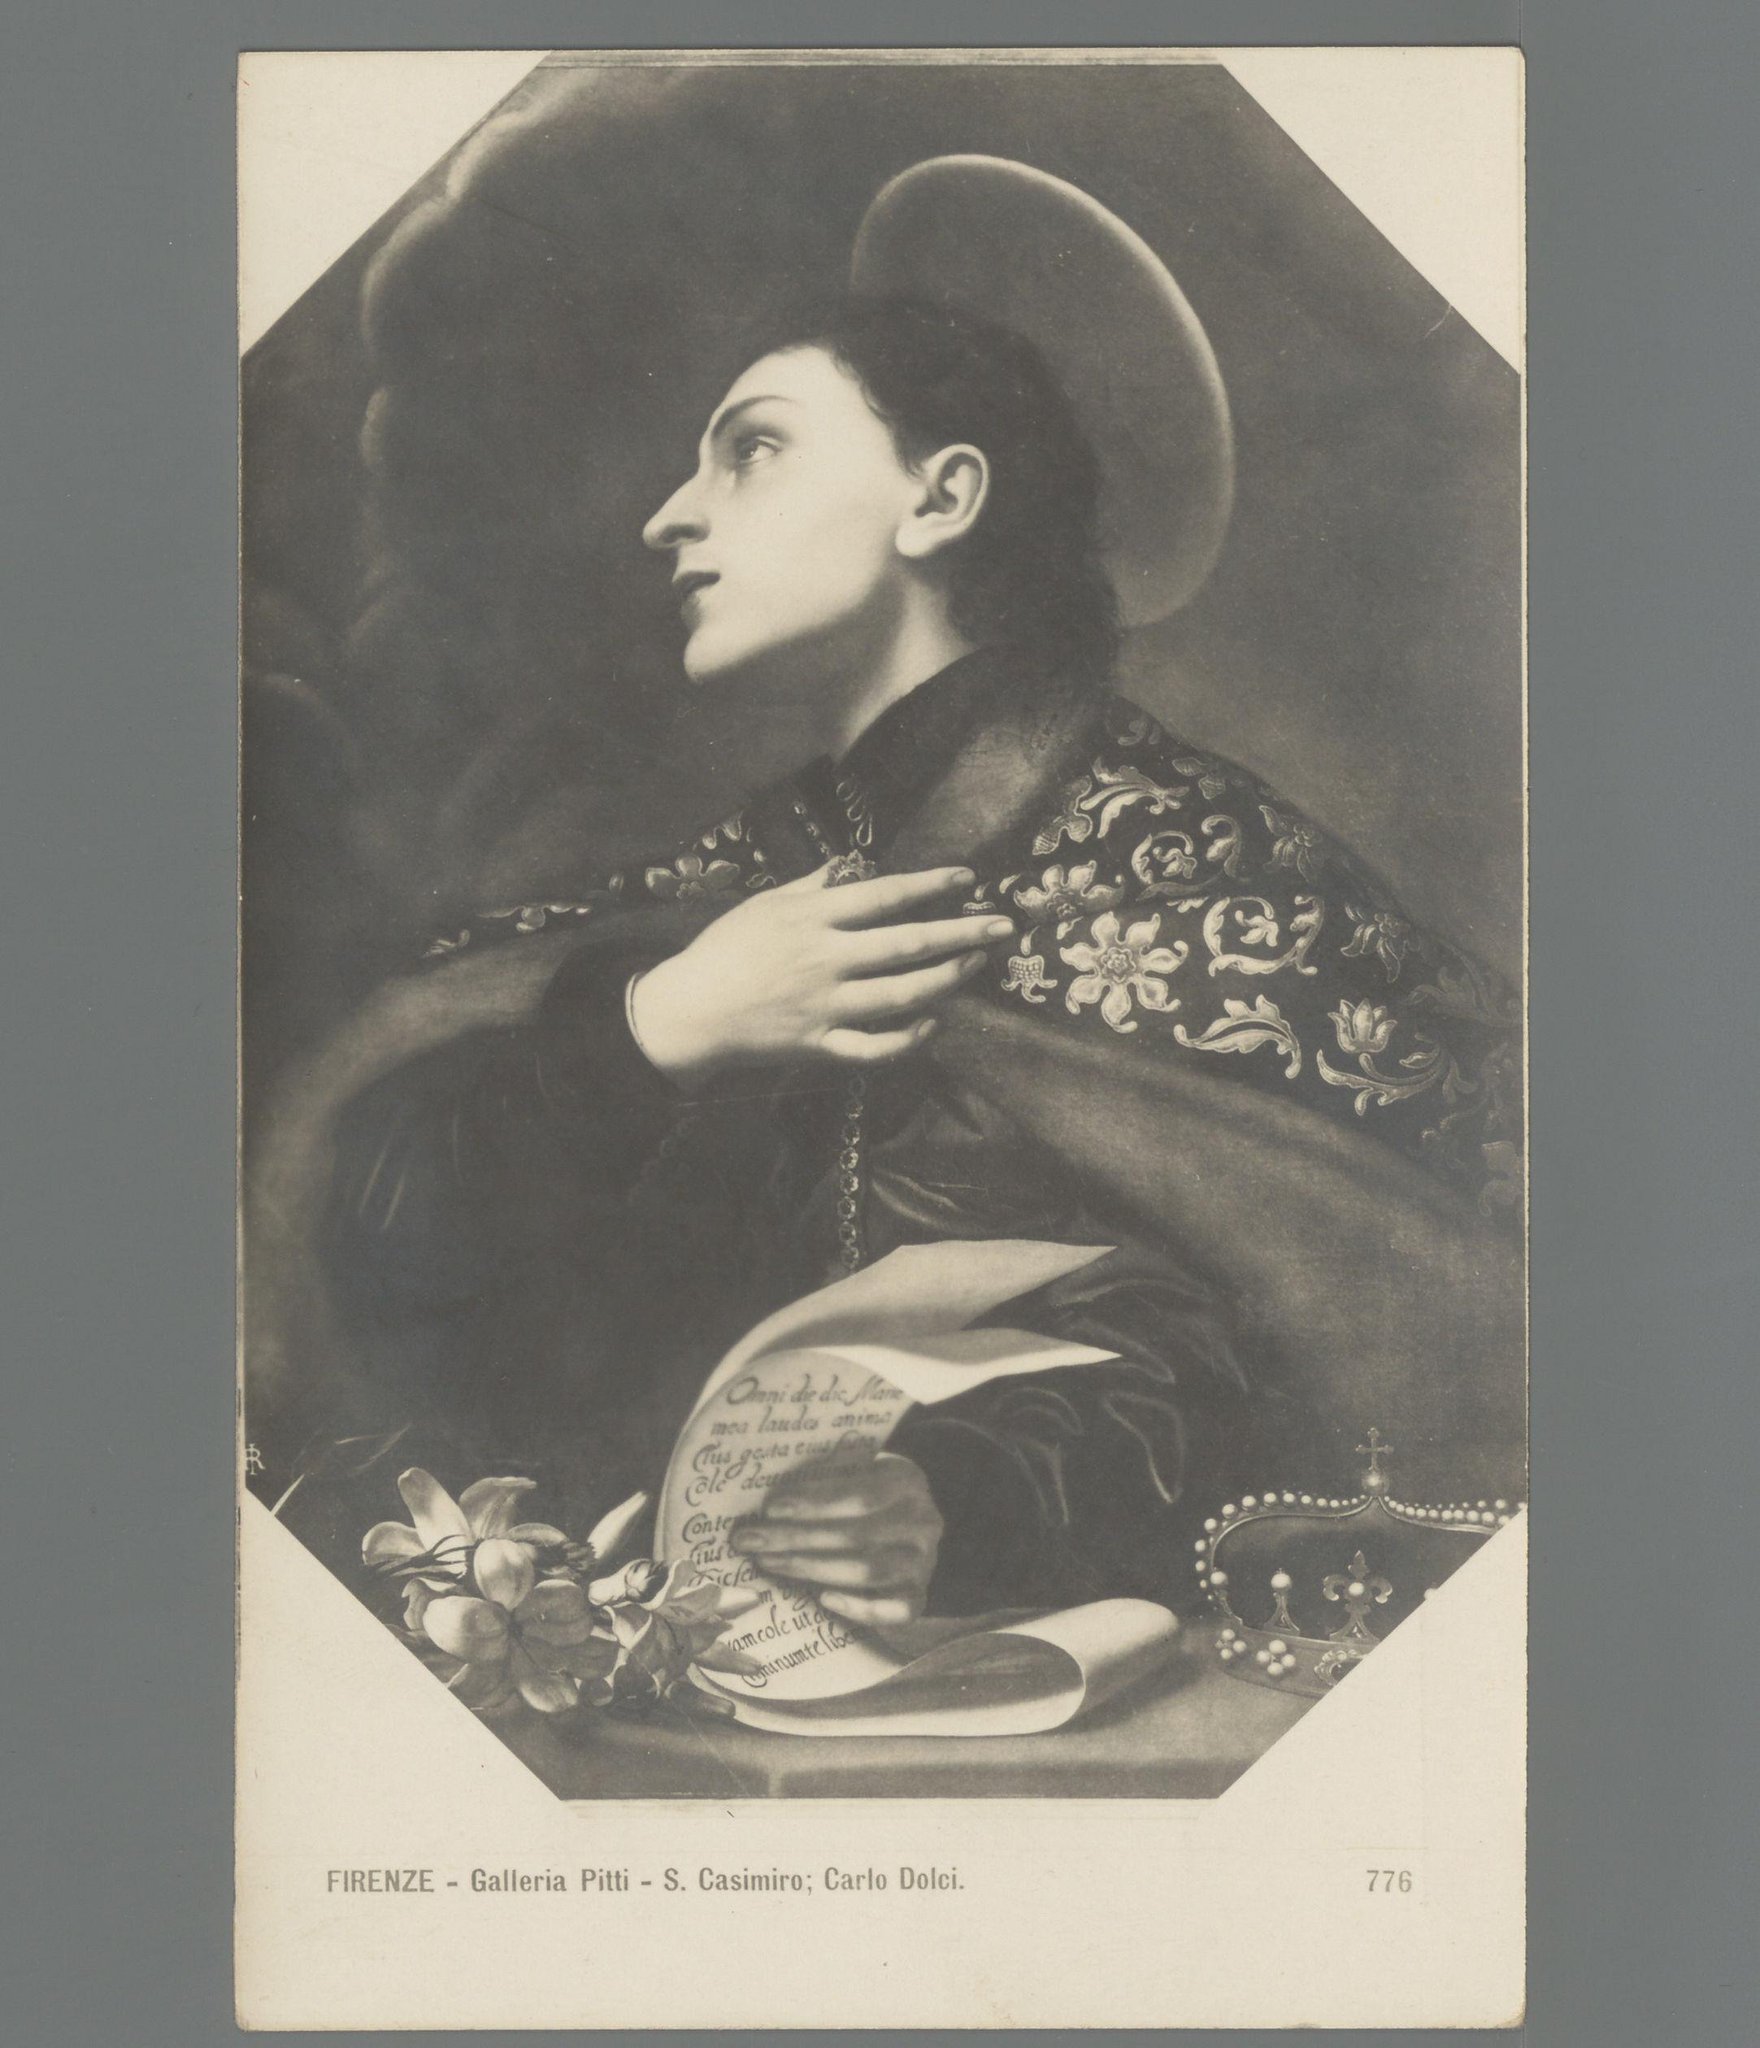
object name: ansichtkaart, prentbriefkaart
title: Firenze. Galleria Pitti. S. Casimiro; Carlo Dolci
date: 1906-1930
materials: photographic support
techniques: photography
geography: florence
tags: clergyman, historical persons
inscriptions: collector's mark: ‘AFE v S’